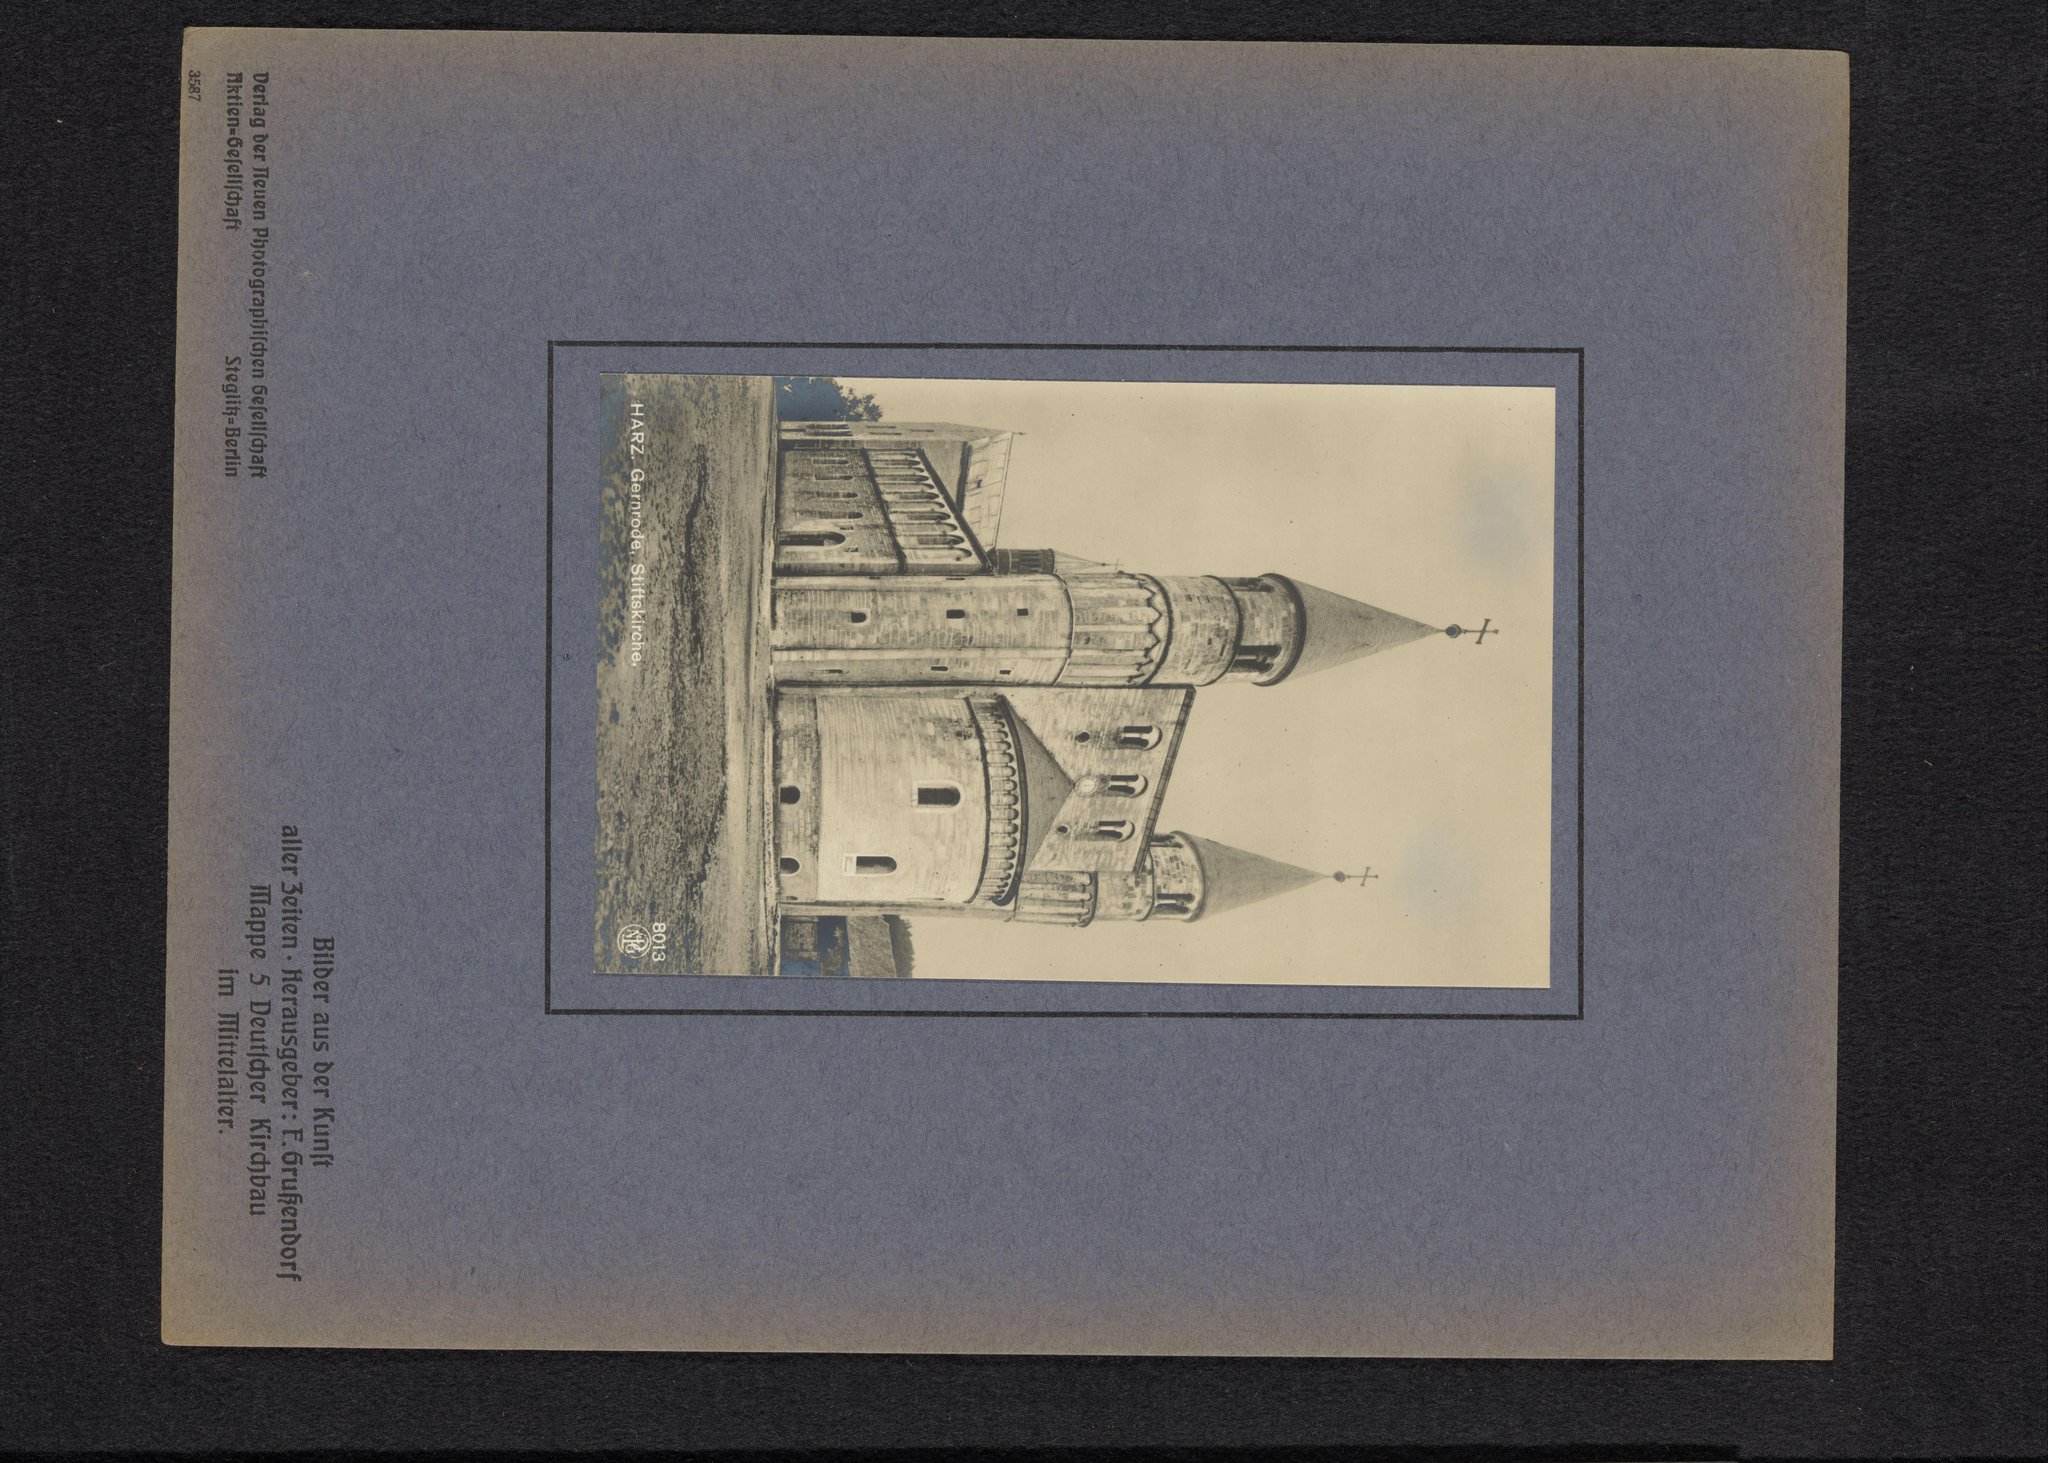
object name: photograph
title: Bilder aus der Kunst aller Zeiten-Herausgeber: F. Grukendorf Mappe 5 Deutscher Kirchbau im Mittelalter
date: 1900-1911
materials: cardboard, photographic support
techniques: gelatin silver print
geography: gernrode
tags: church (exterior)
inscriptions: number: ‘3587’, number: ‘8013’